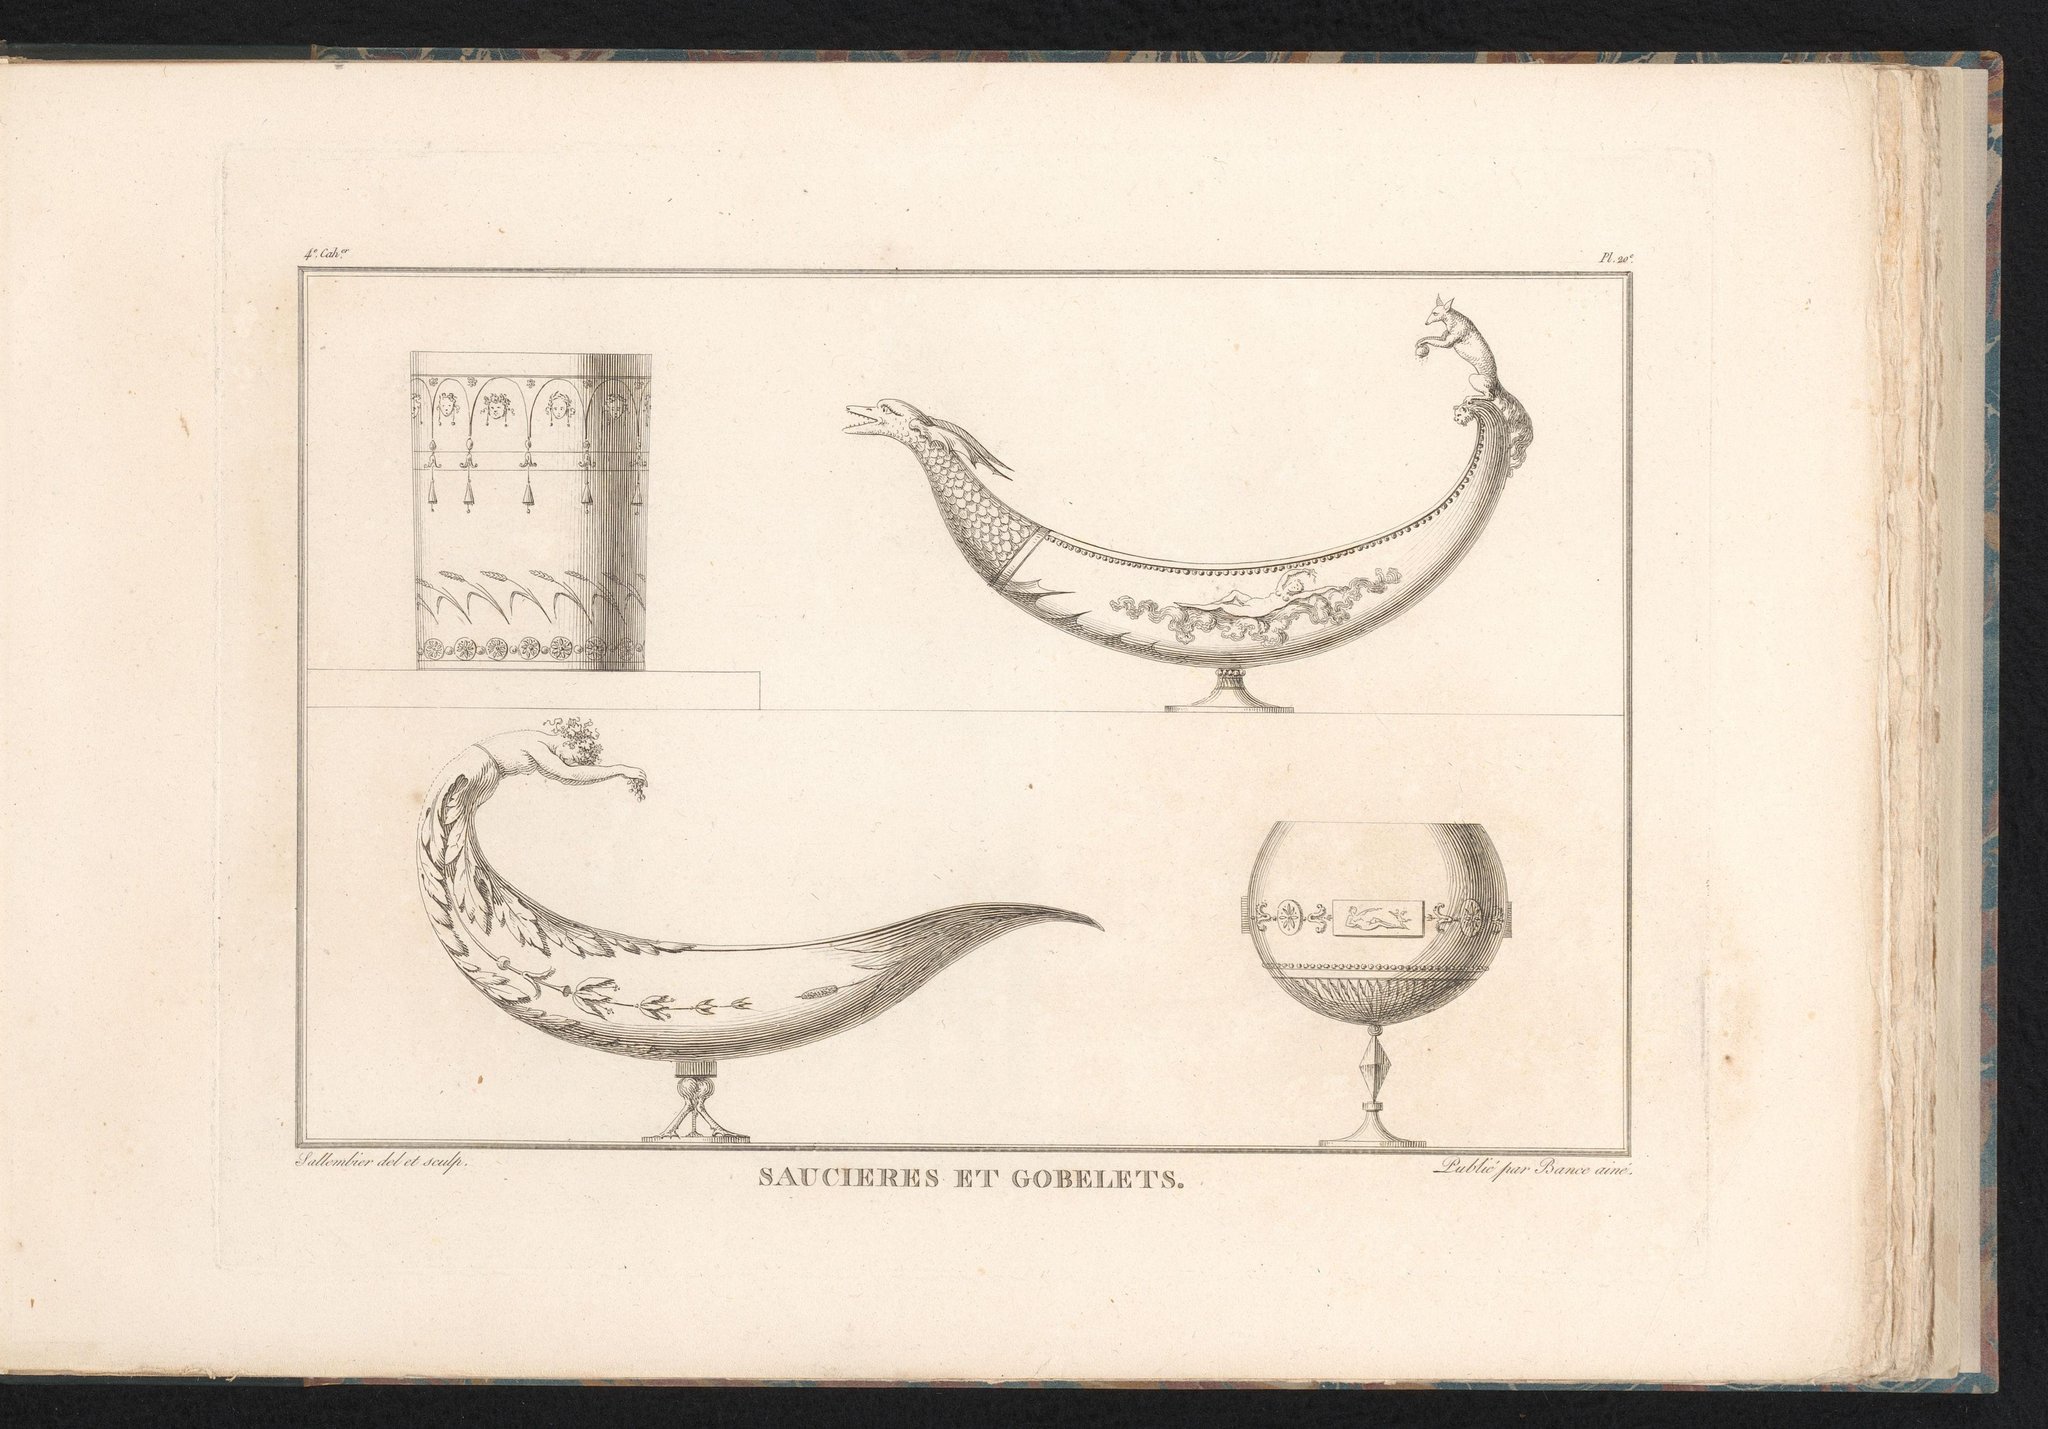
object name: ornament print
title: Sauskommen en bokalen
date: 1805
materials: paper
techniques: etching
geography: paris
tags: sauces, mug, beaker, goblet, (story of) venus (aphrodite), dinner-service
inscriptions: number: ‘4.e Cah.er’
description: Ontwerpen voor sauskommen en bokalen met een draak, Venus, een vos en bladmotieven. Prent maakt deel uit van een album.